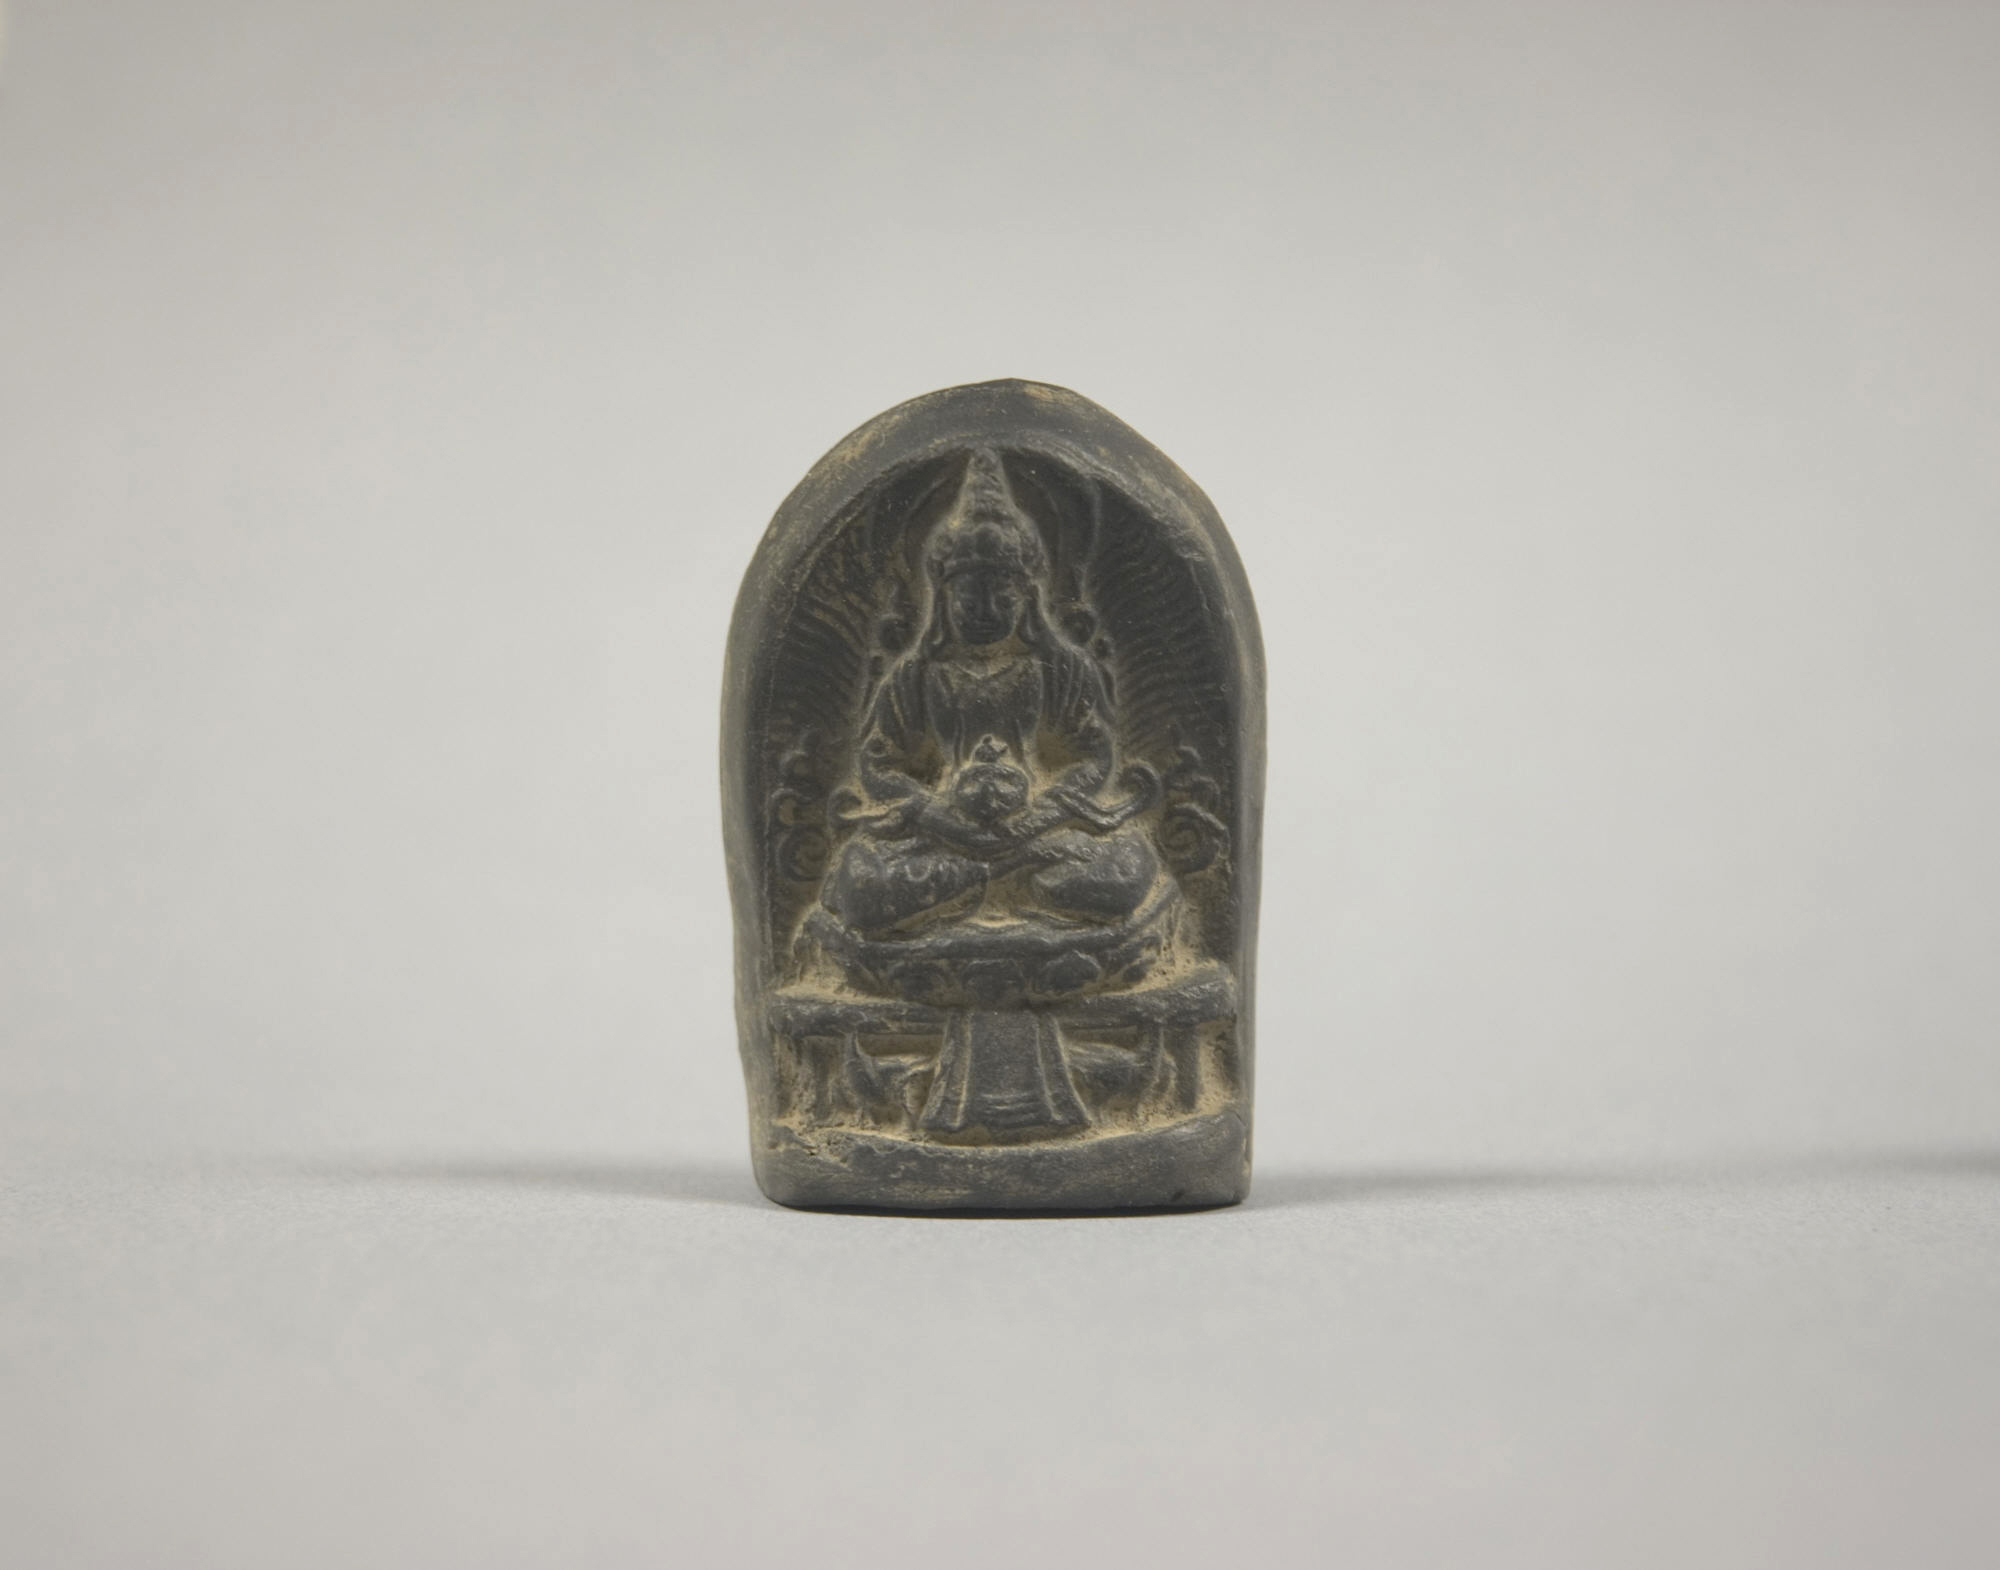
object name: votive plaque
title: Votive Plaque with Amitāyus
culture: tibetan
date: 701-800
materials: clay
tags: buddhism,buddha